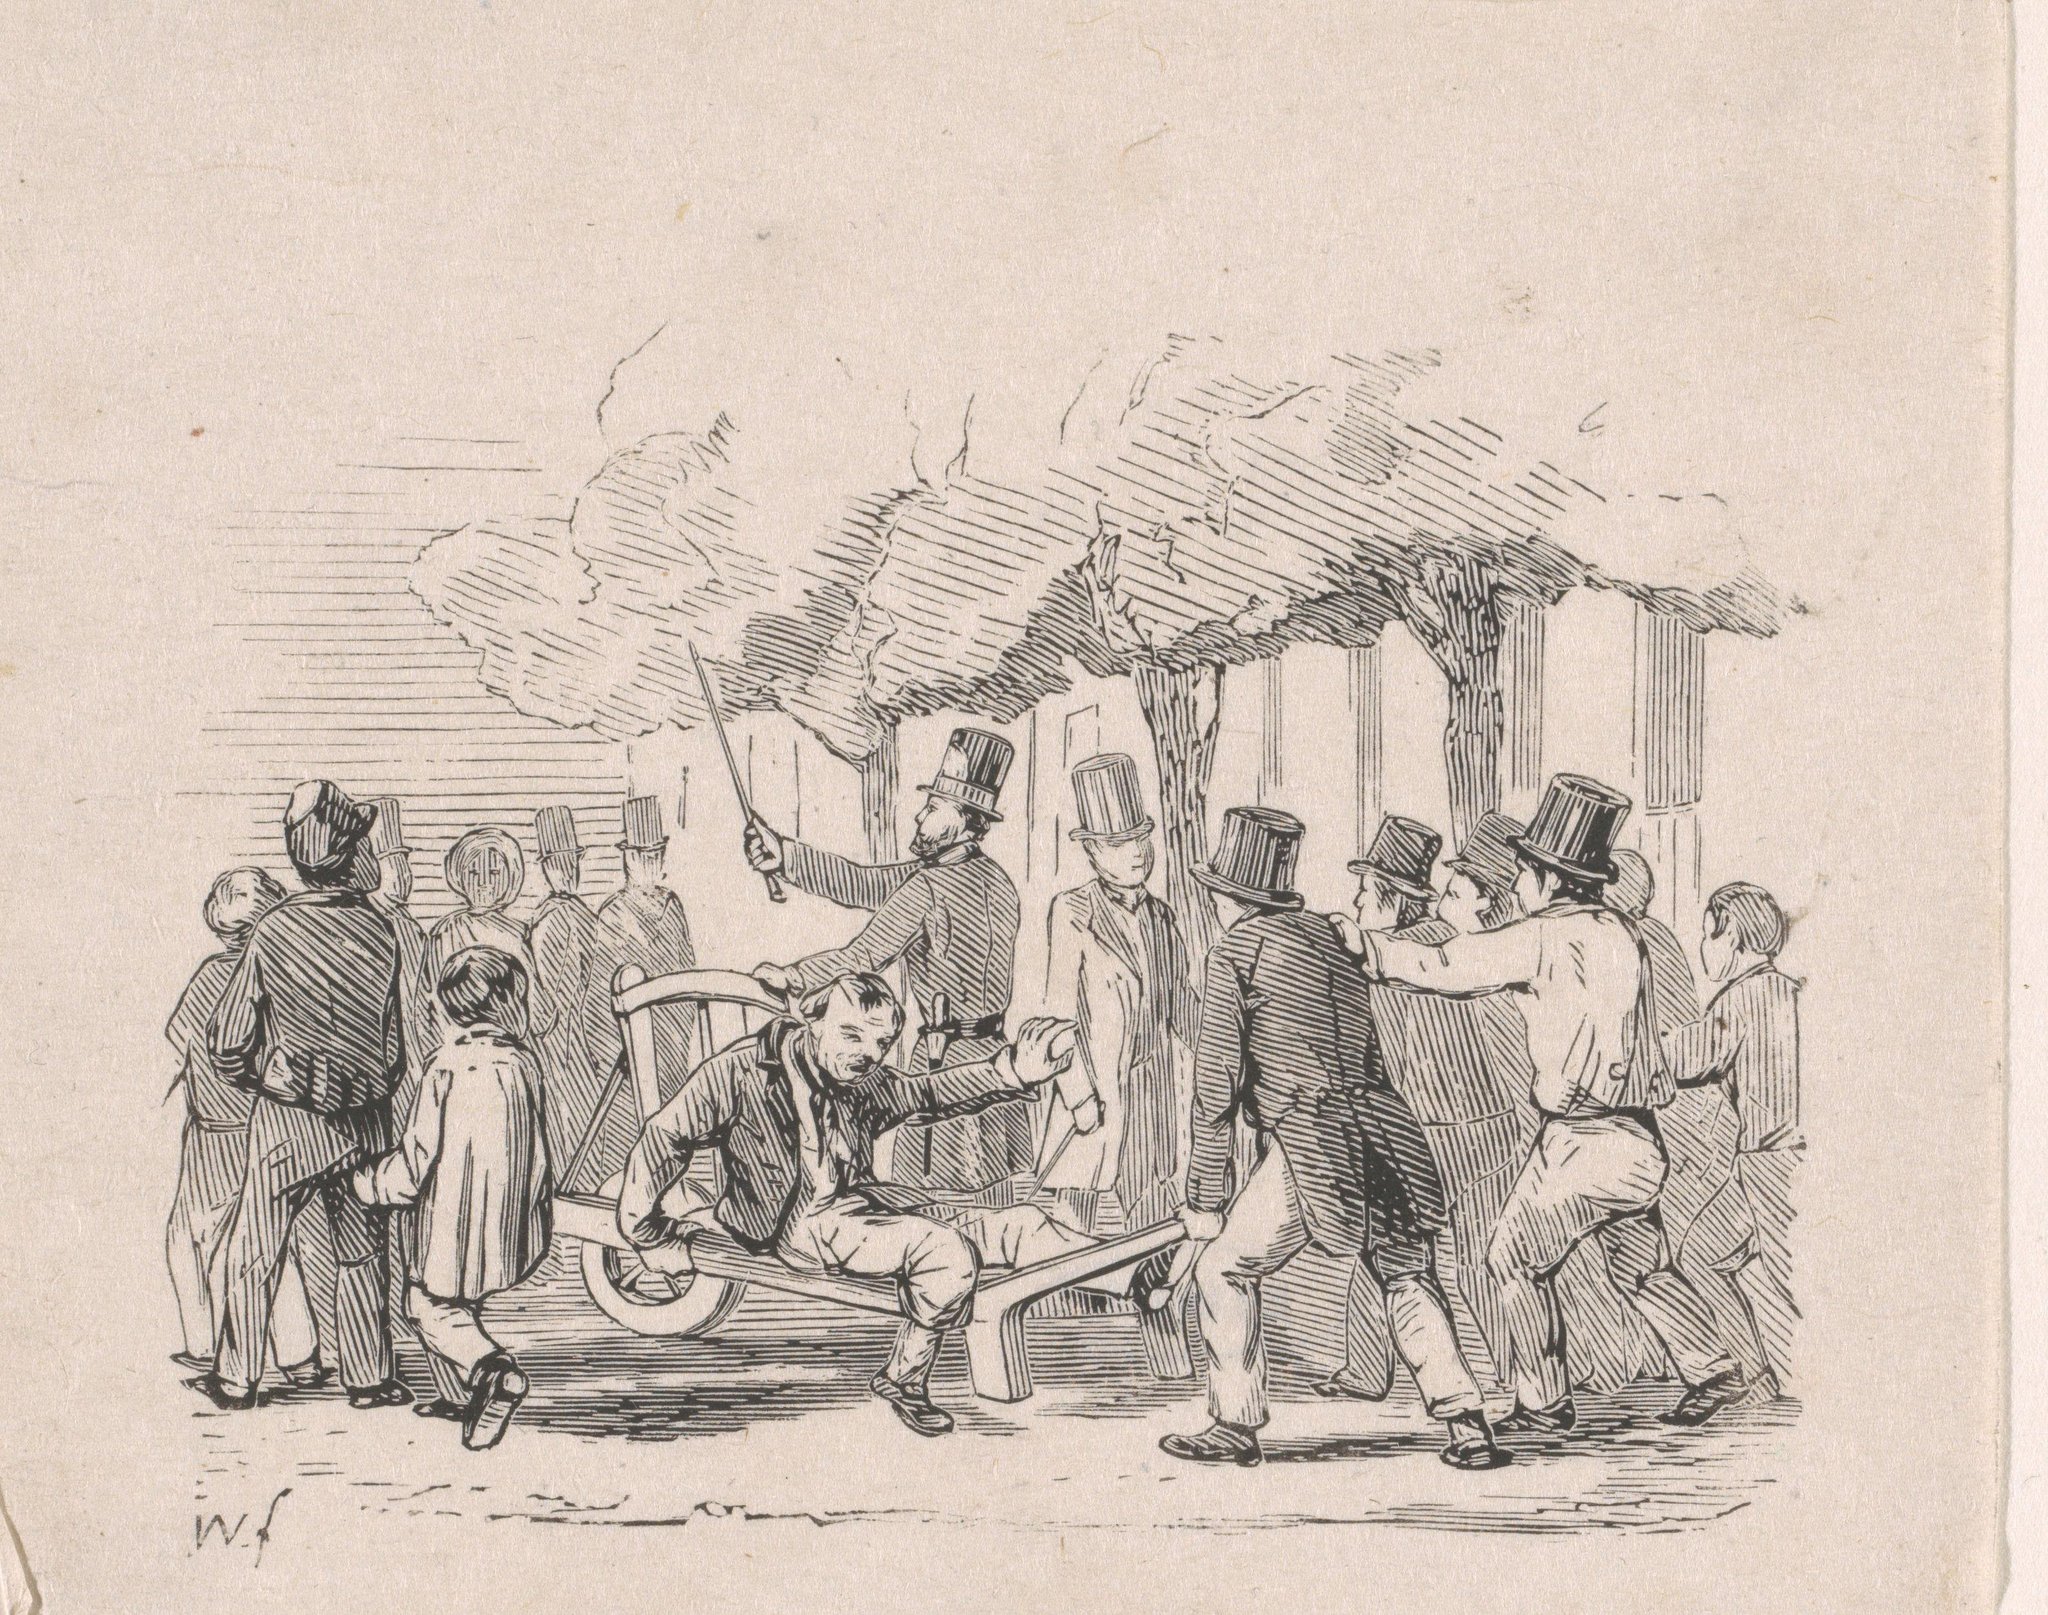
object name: print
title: Dronkaard op een kruiwagen voortgeduwd door een groep mannen op straat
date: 1838-1912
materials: paper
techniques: engraving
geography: netherlands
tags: drunkard, adult man, walking, wheelbarrow, alcoholic drinks